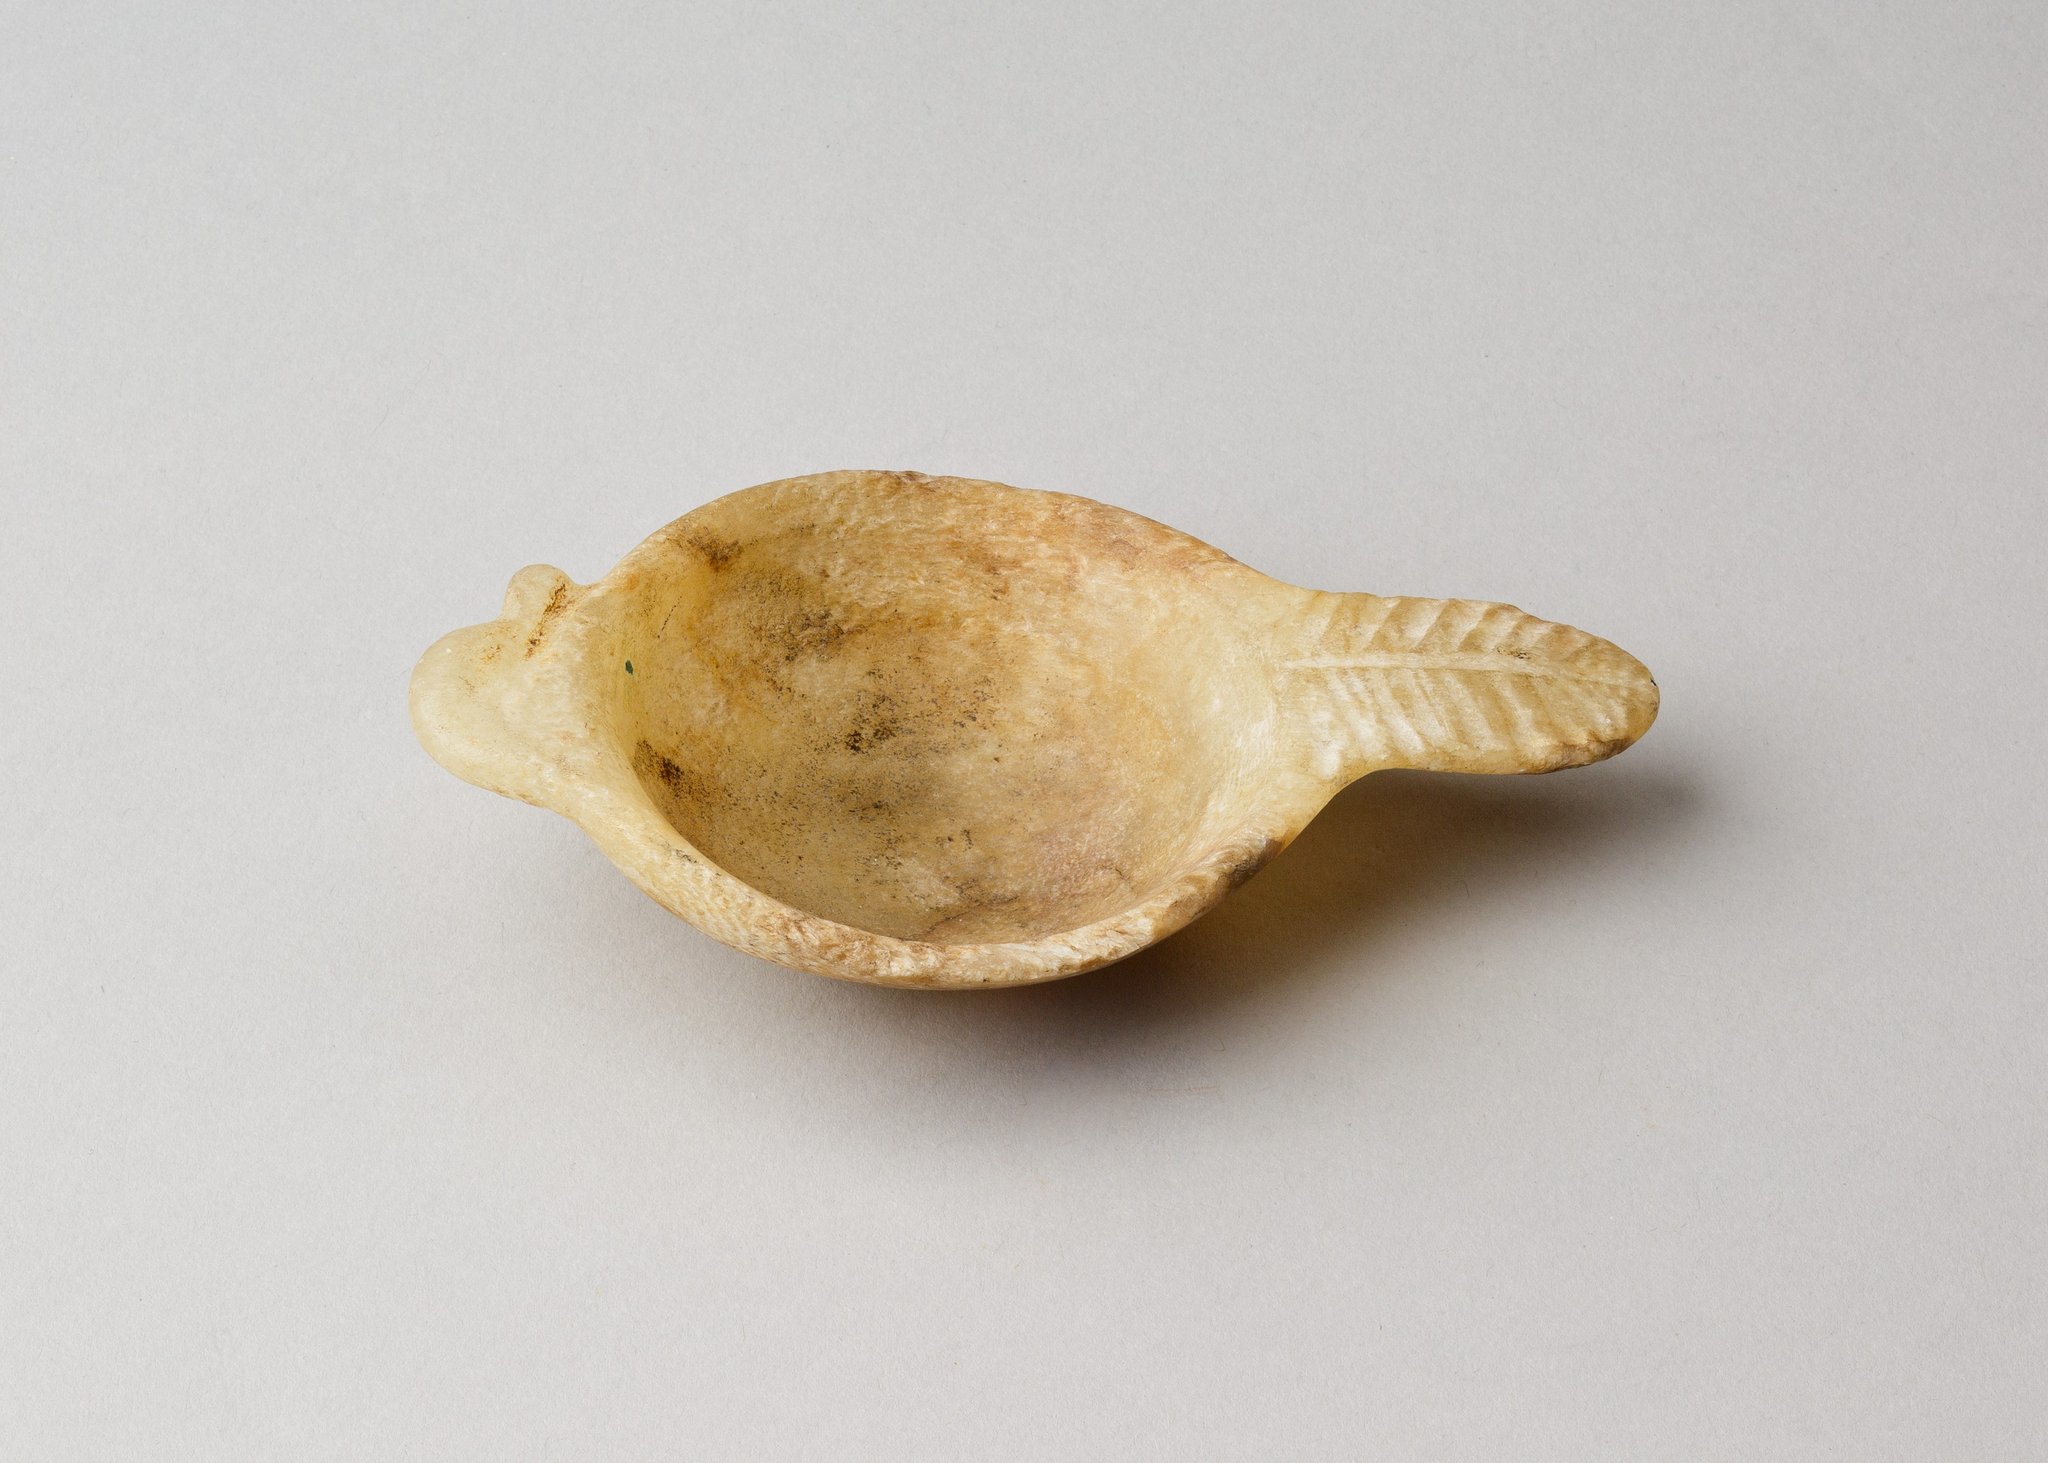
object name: cosmetic, spoon, duck, goose, bird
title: Cosmetic spoon with duck-head handle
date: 1550-1295 BCE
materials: stone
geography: egypt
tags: ducks